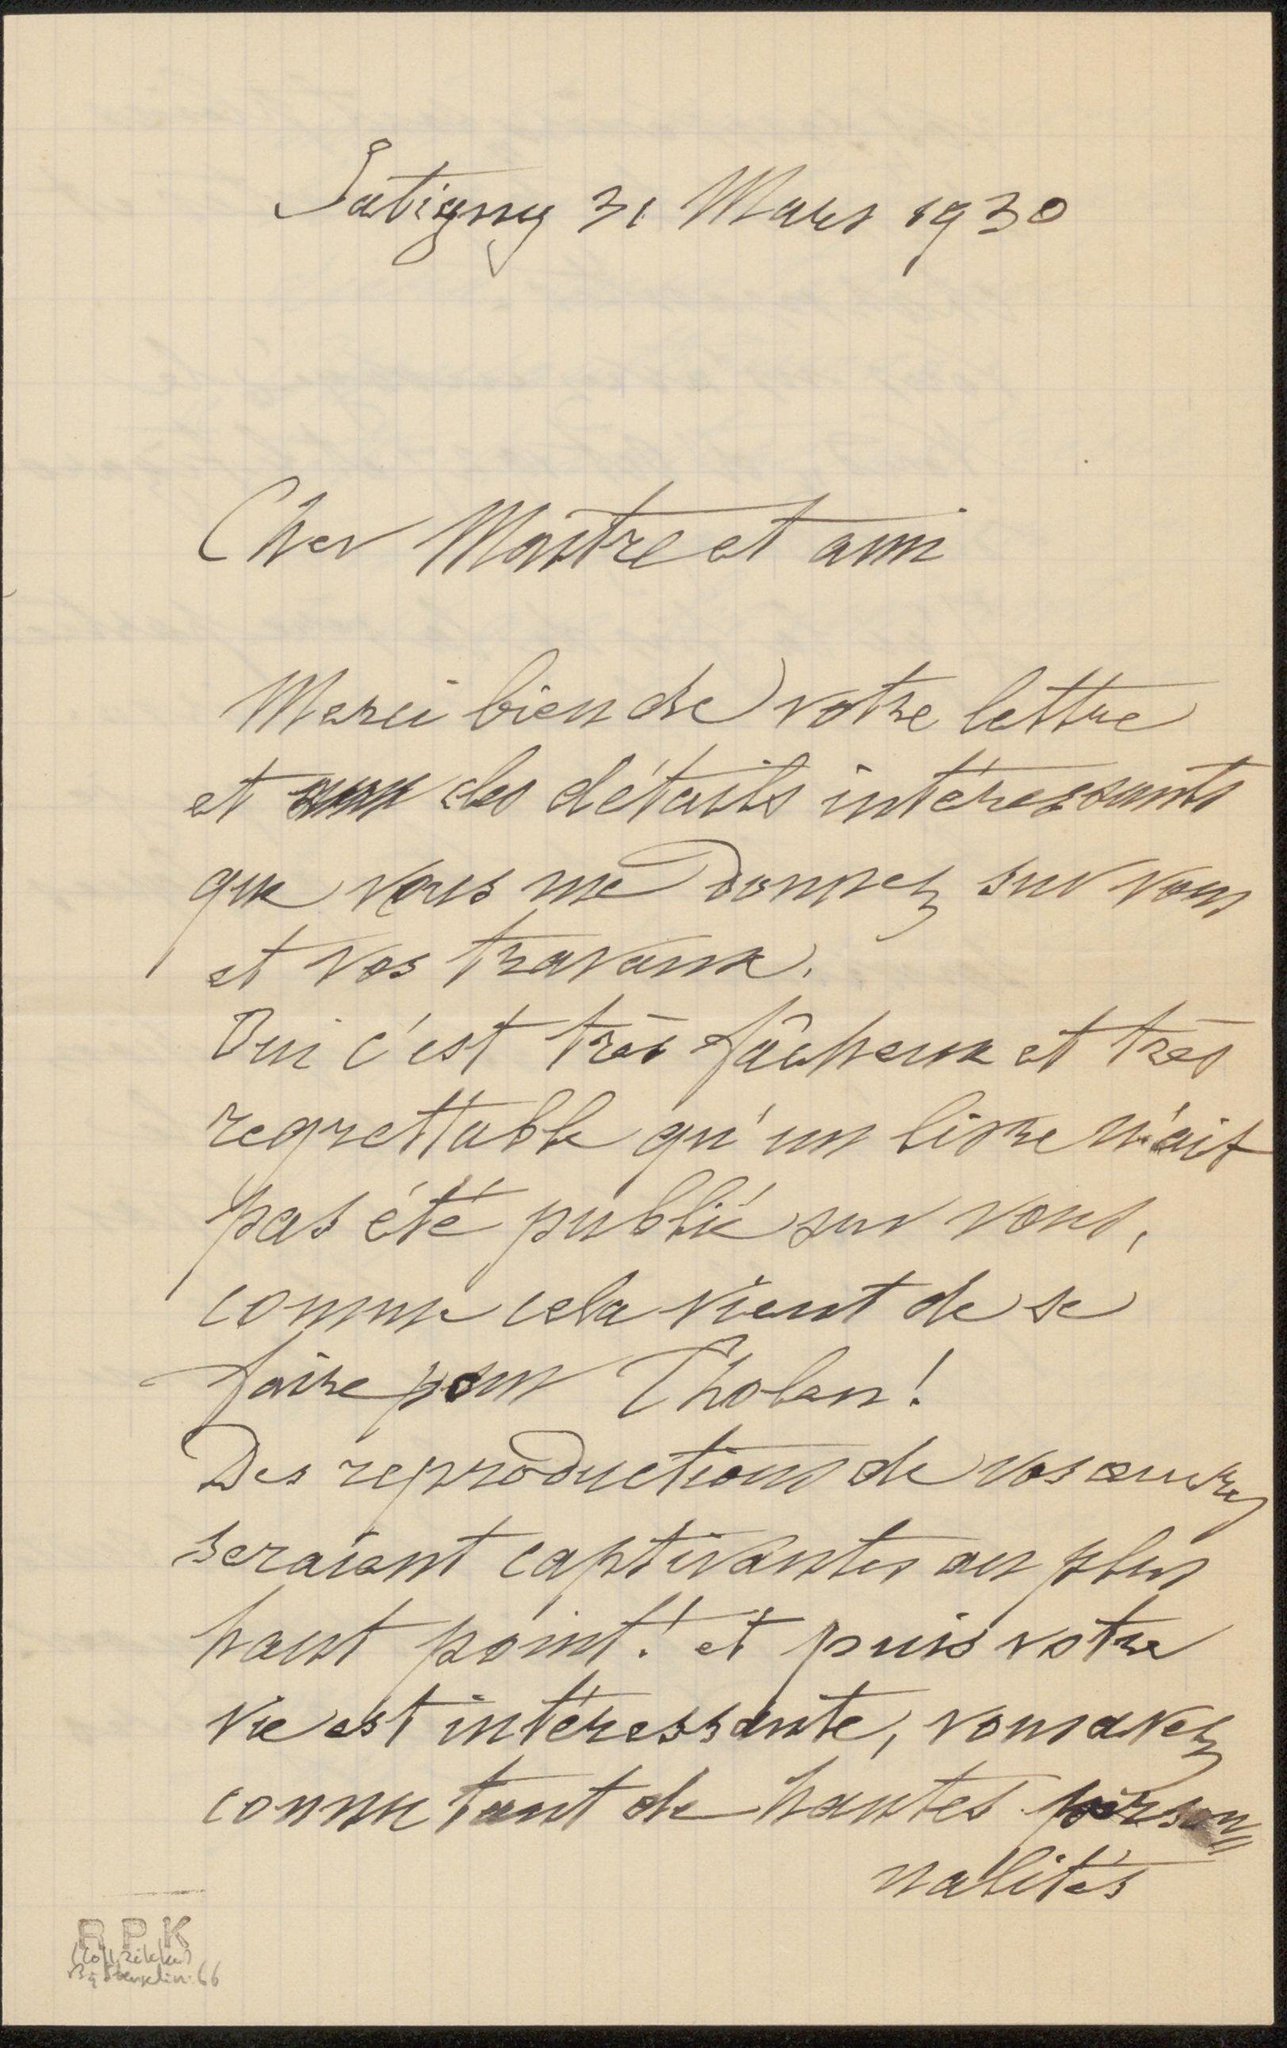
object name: letter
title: Brief aan Philip Zilcken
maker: alphonse stengelin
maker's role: painter, print maker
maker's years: 1852-1938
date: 1930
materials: ink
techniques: pen, writing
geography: satigny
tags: print maker, willem bastiaan tholen, the hague, draughtsman, philip zilcken, family life, painting (including book-illumination, miniature-painting), printed matter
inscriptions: collector's mark: ‘RPK’